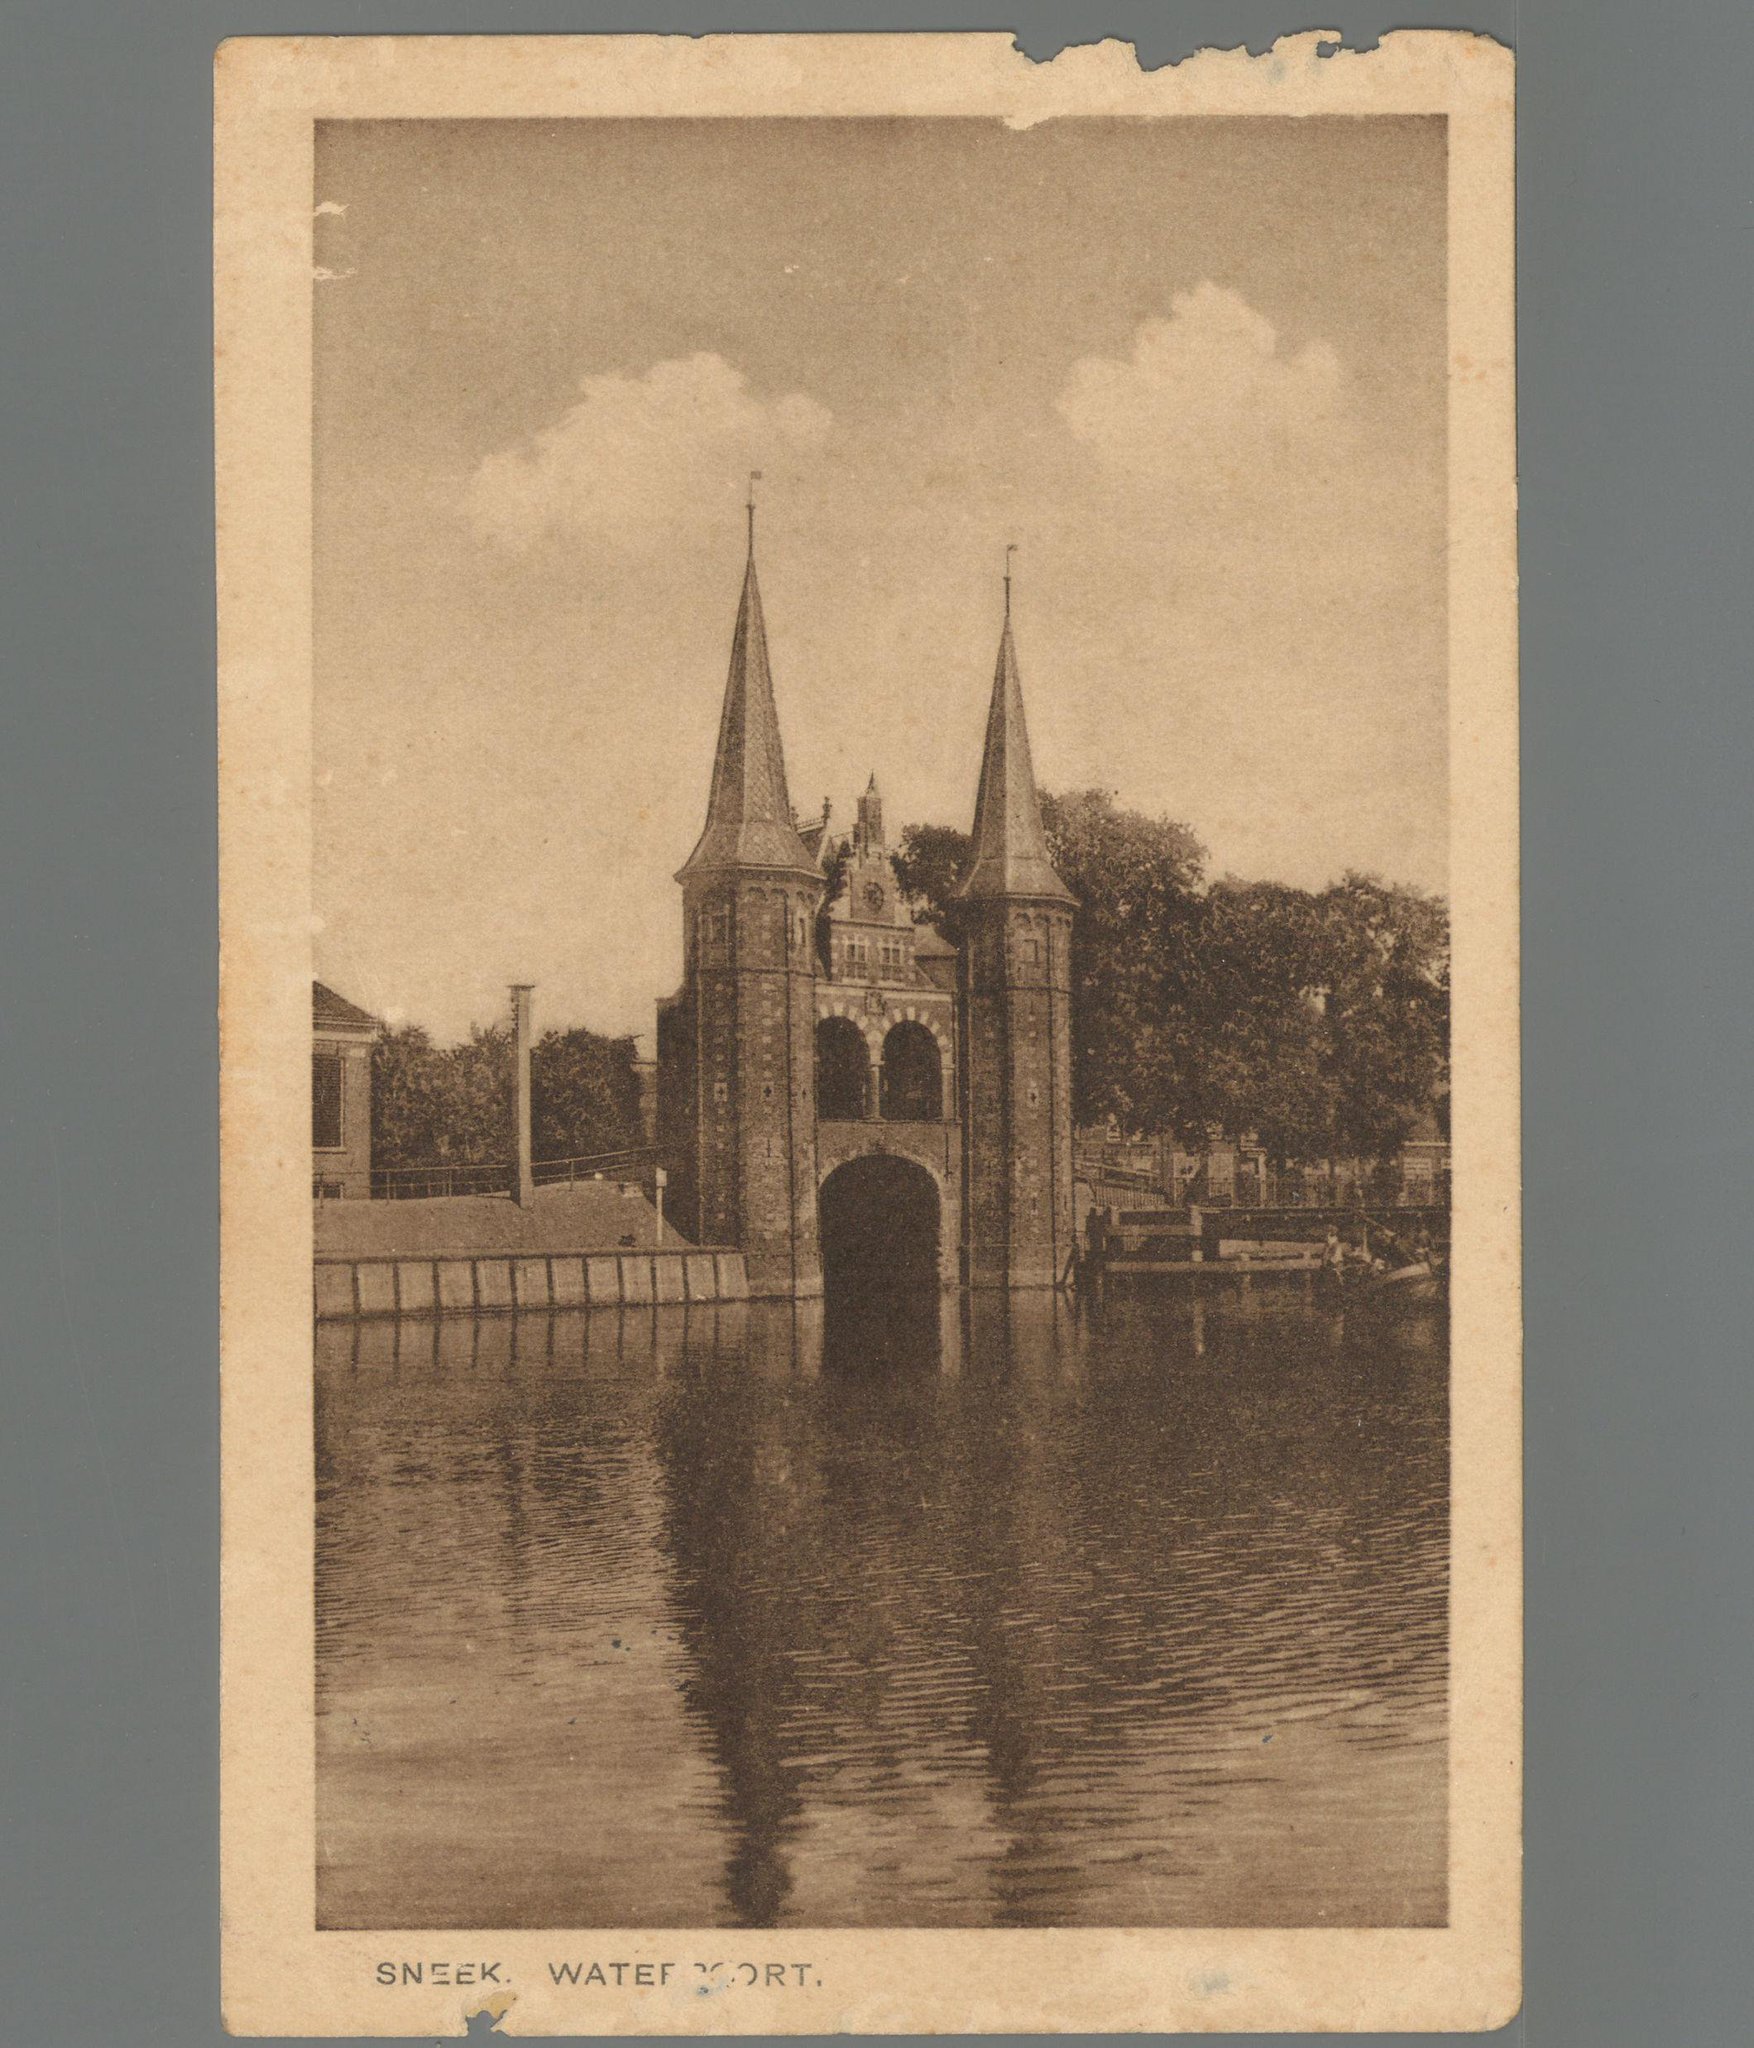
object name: ansichtkaart, prentbriefkaart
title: SNEEK. WATERPOORT.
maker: Anonymous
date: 1913-1930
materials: cardboard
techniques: photograph, writing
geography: sneek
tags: gate, entrance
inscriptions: postage stamp